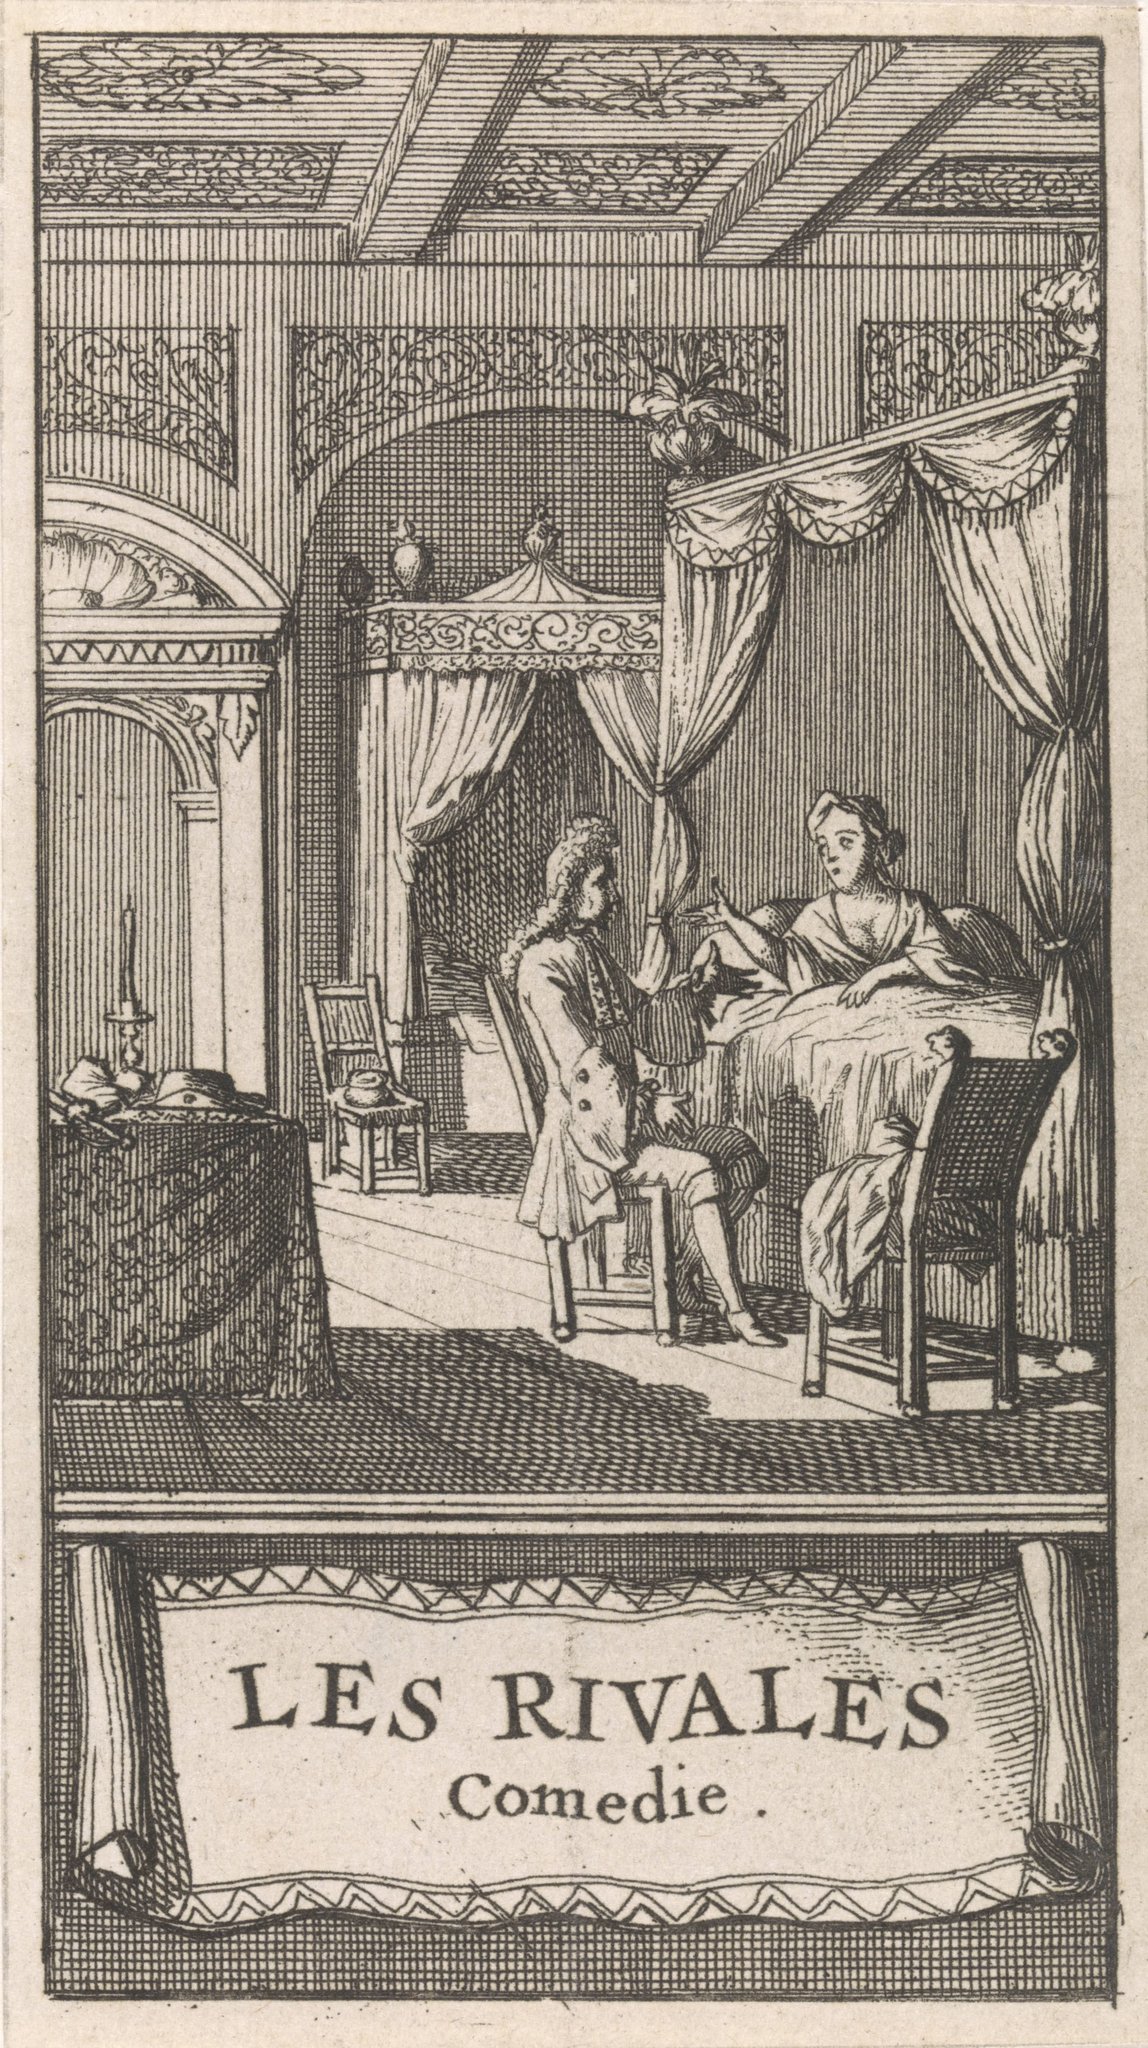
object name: print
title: Titelpagina voor "Les Rivales", in: P. Quinault, Le theatre, deel II, 1697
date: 1697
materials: paper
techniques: etching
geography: amsterdam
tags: bedroom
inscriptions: collector's mark: Lugt 2228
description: Titelpagina voor het toneelstuk "Les Rivales" in deel II van: Quinault, Philippe. Le theatre, 2 delen. Amsterdam: Antoine Schelte, 1697.